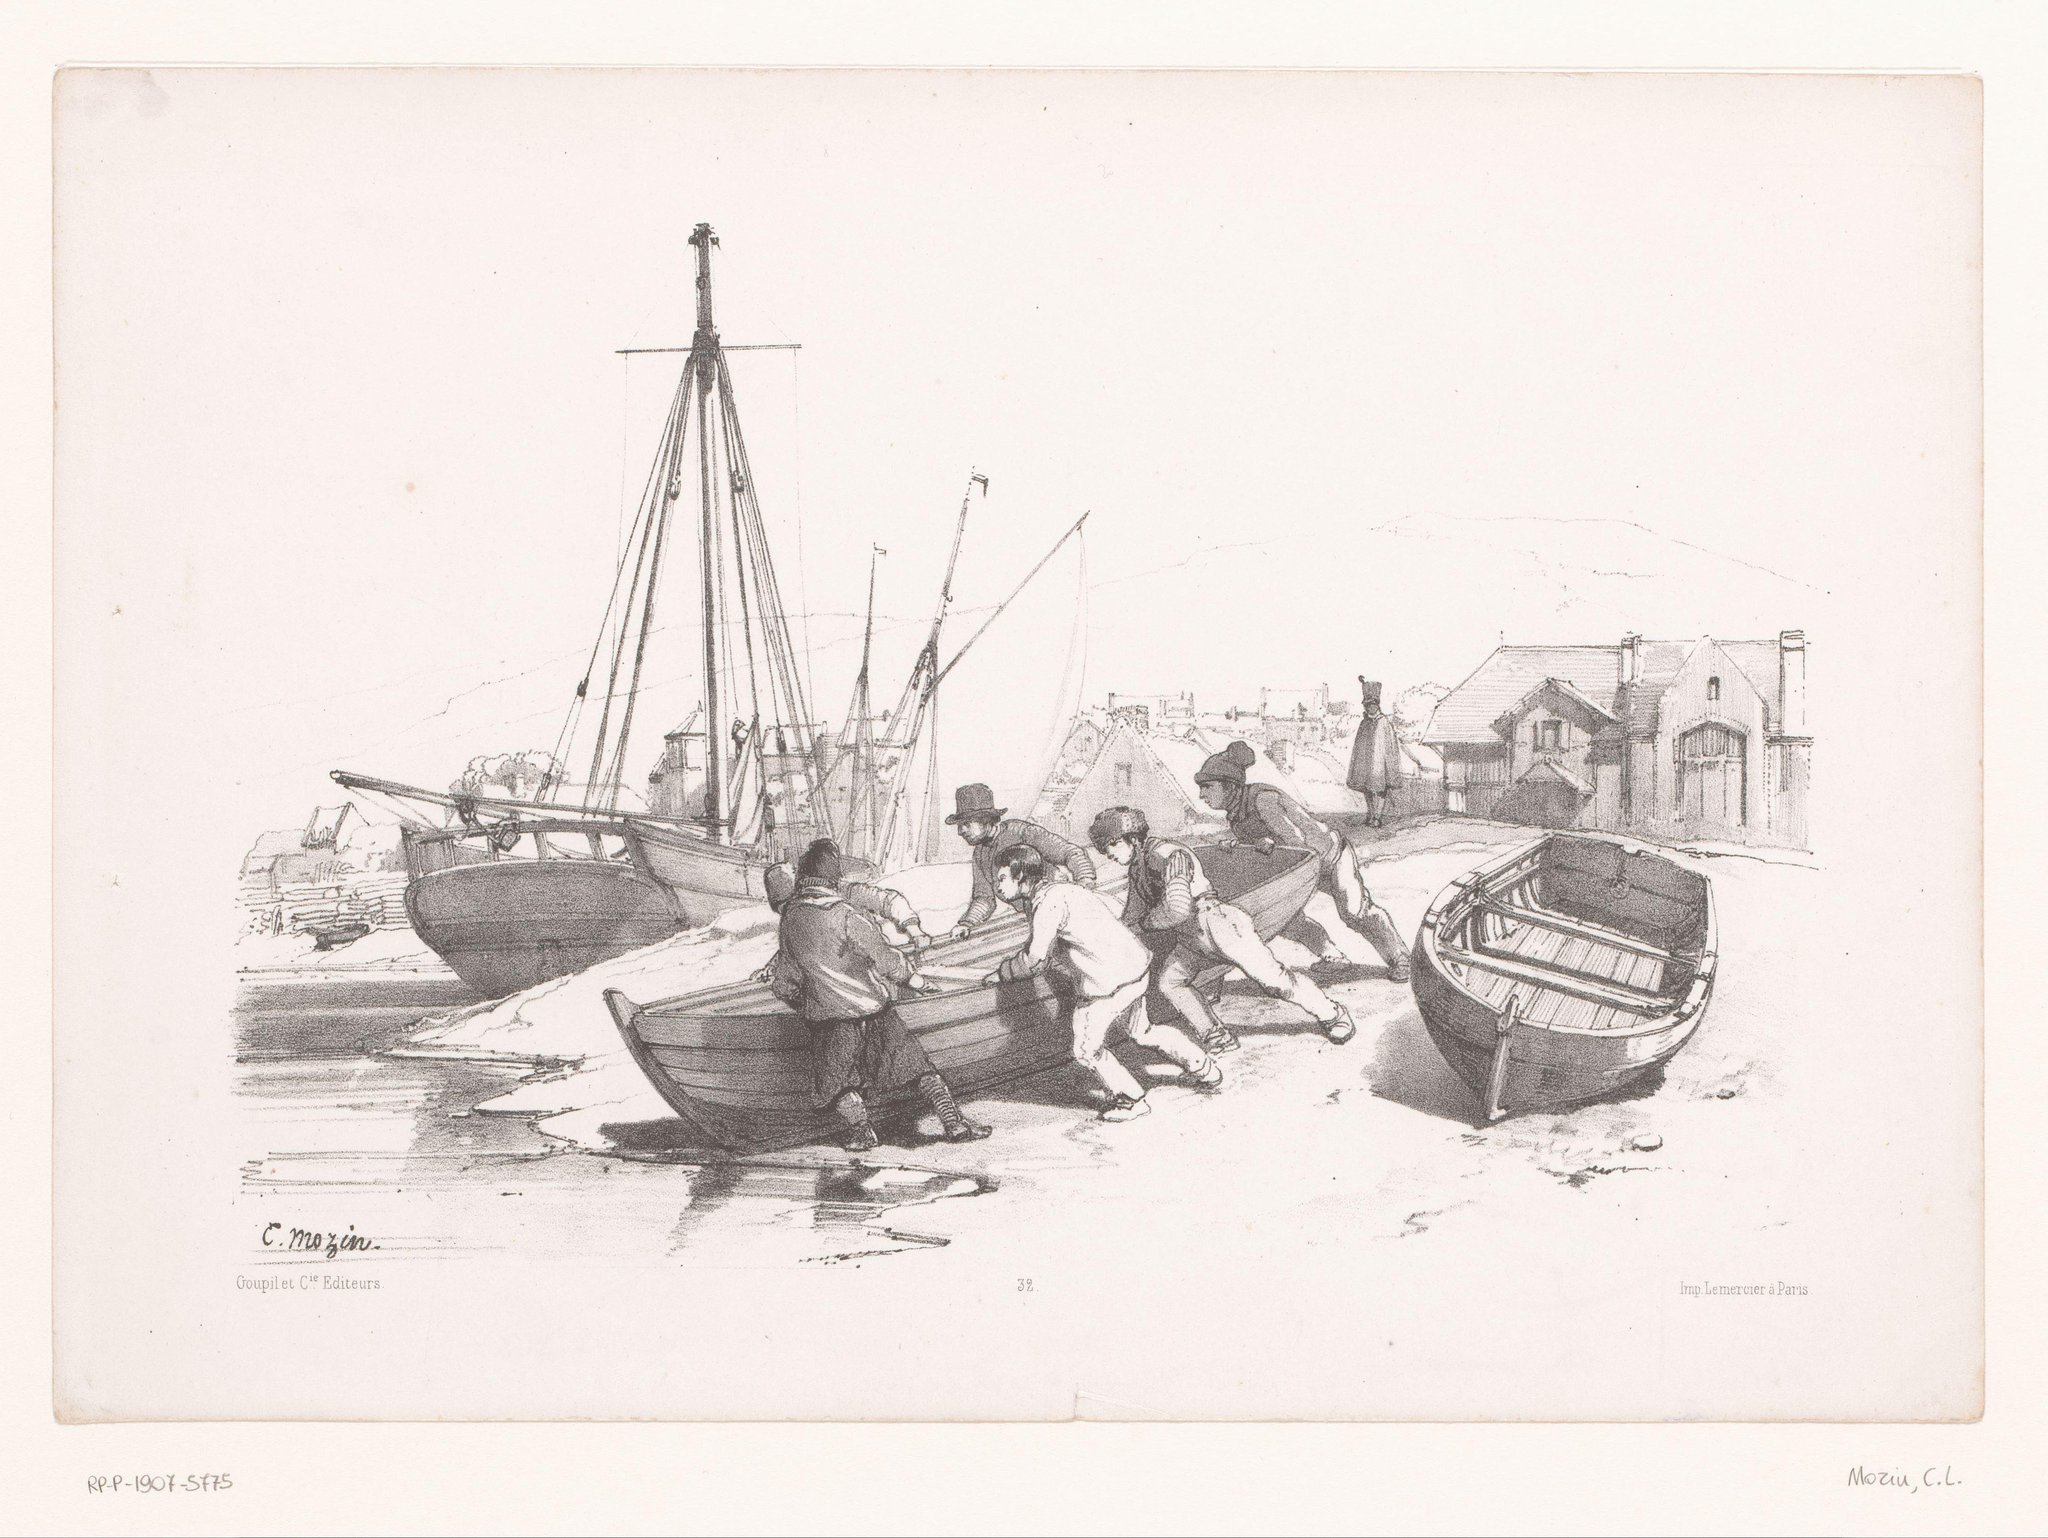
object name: print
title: Mannen duwen roeiboot van land naar water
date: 1850-1884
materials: paper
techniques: lithograph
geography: paris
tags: sailing-ship, sailing-boat, rowing-boat, canoe, etc.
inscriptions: collector's mark: Lugt 2228